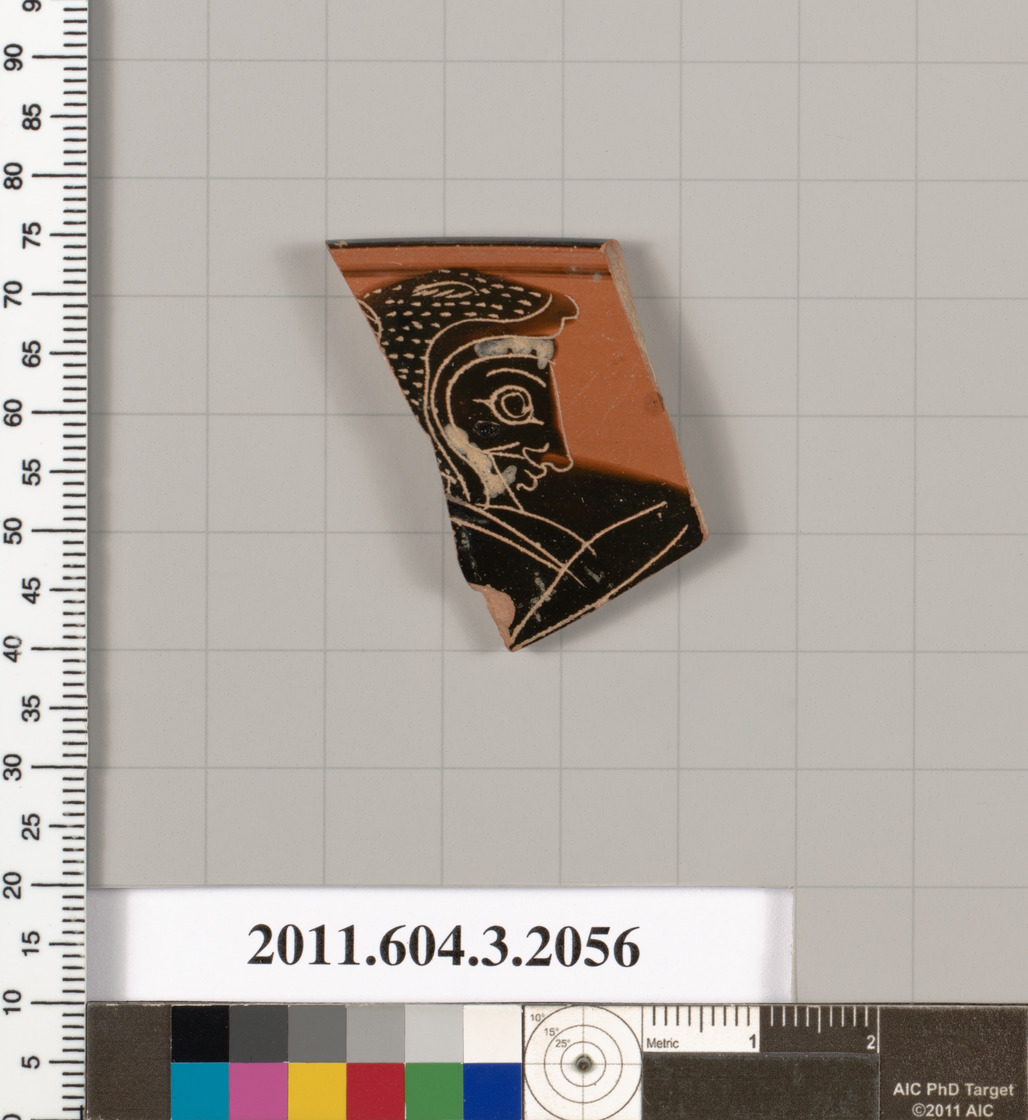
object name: kylix fragment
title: Terracotta rim fragment of a kylix (drinking cup)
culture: greek, attic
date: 550-501 BCE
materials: terracotta